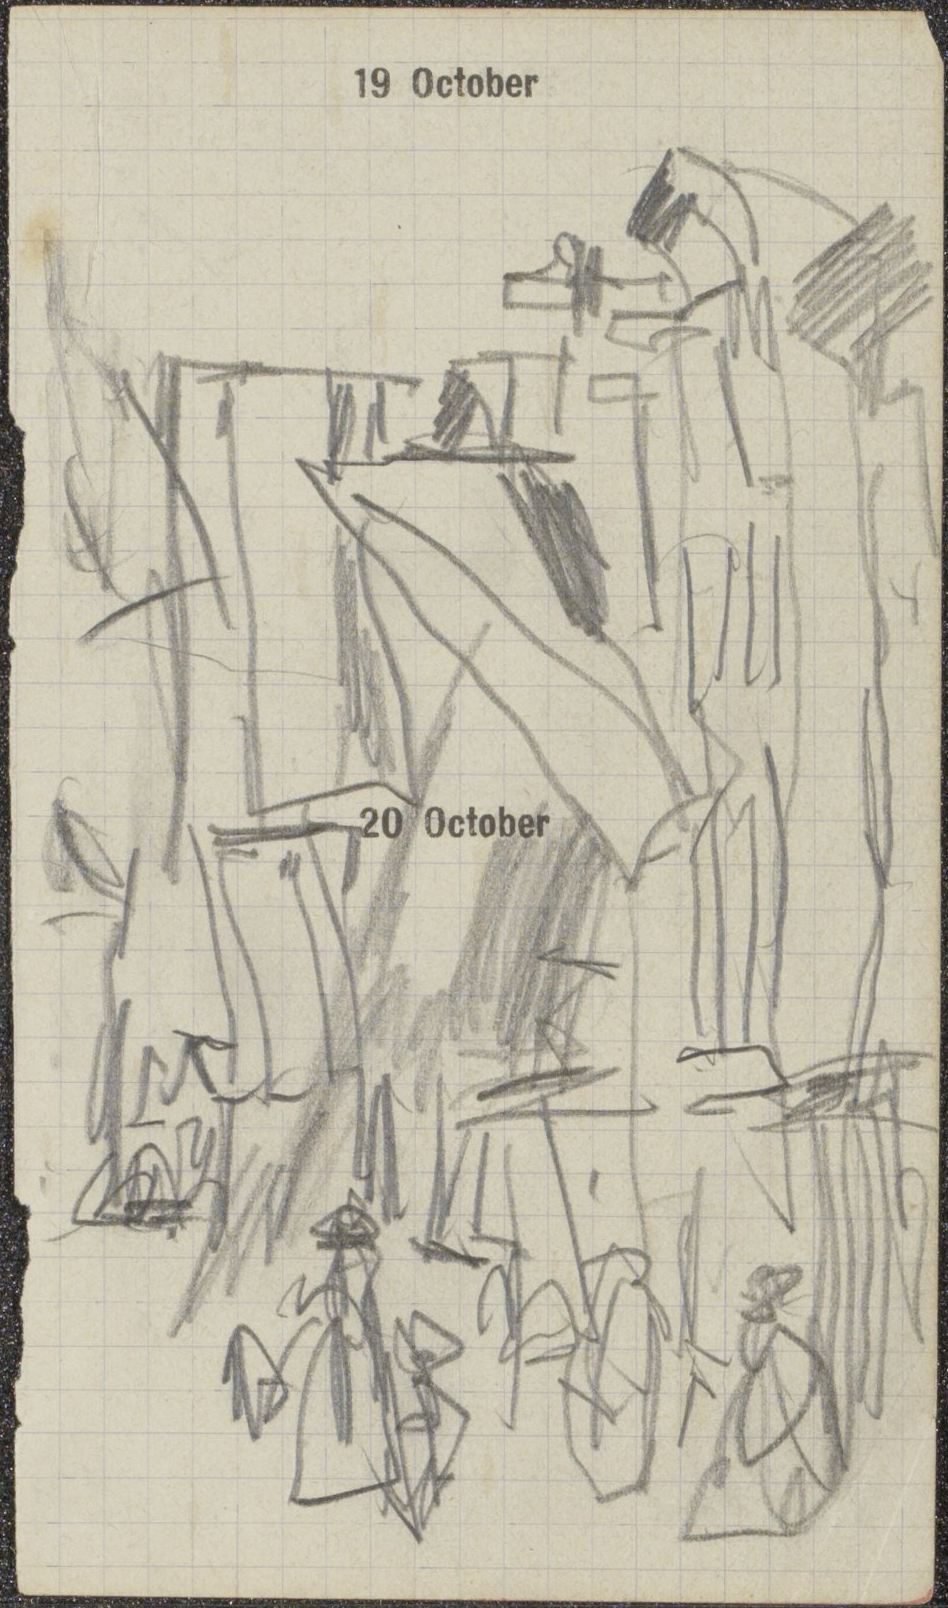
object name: drawing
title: Straat met vlaggen in Amsterdam, mogelijk de Hartenstraat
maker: george hendrik breitner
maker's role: draughtsman, painter, print maker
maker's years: 1857-1923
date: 1886-1923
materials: pencil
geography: amsterdam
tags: street (+ city(-scape) with figures, staffage), flag, colours (as symbol of the state, etc.)